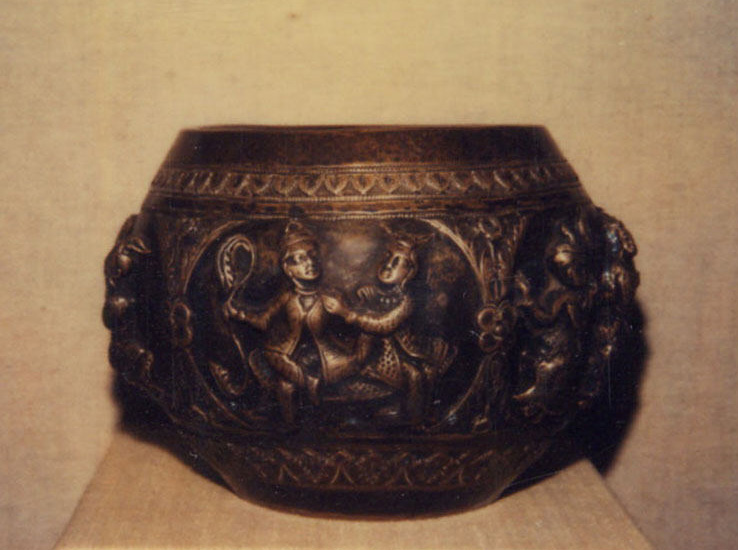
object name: bowl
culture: burmese or thai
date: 1801-1900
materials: silver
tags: men,women